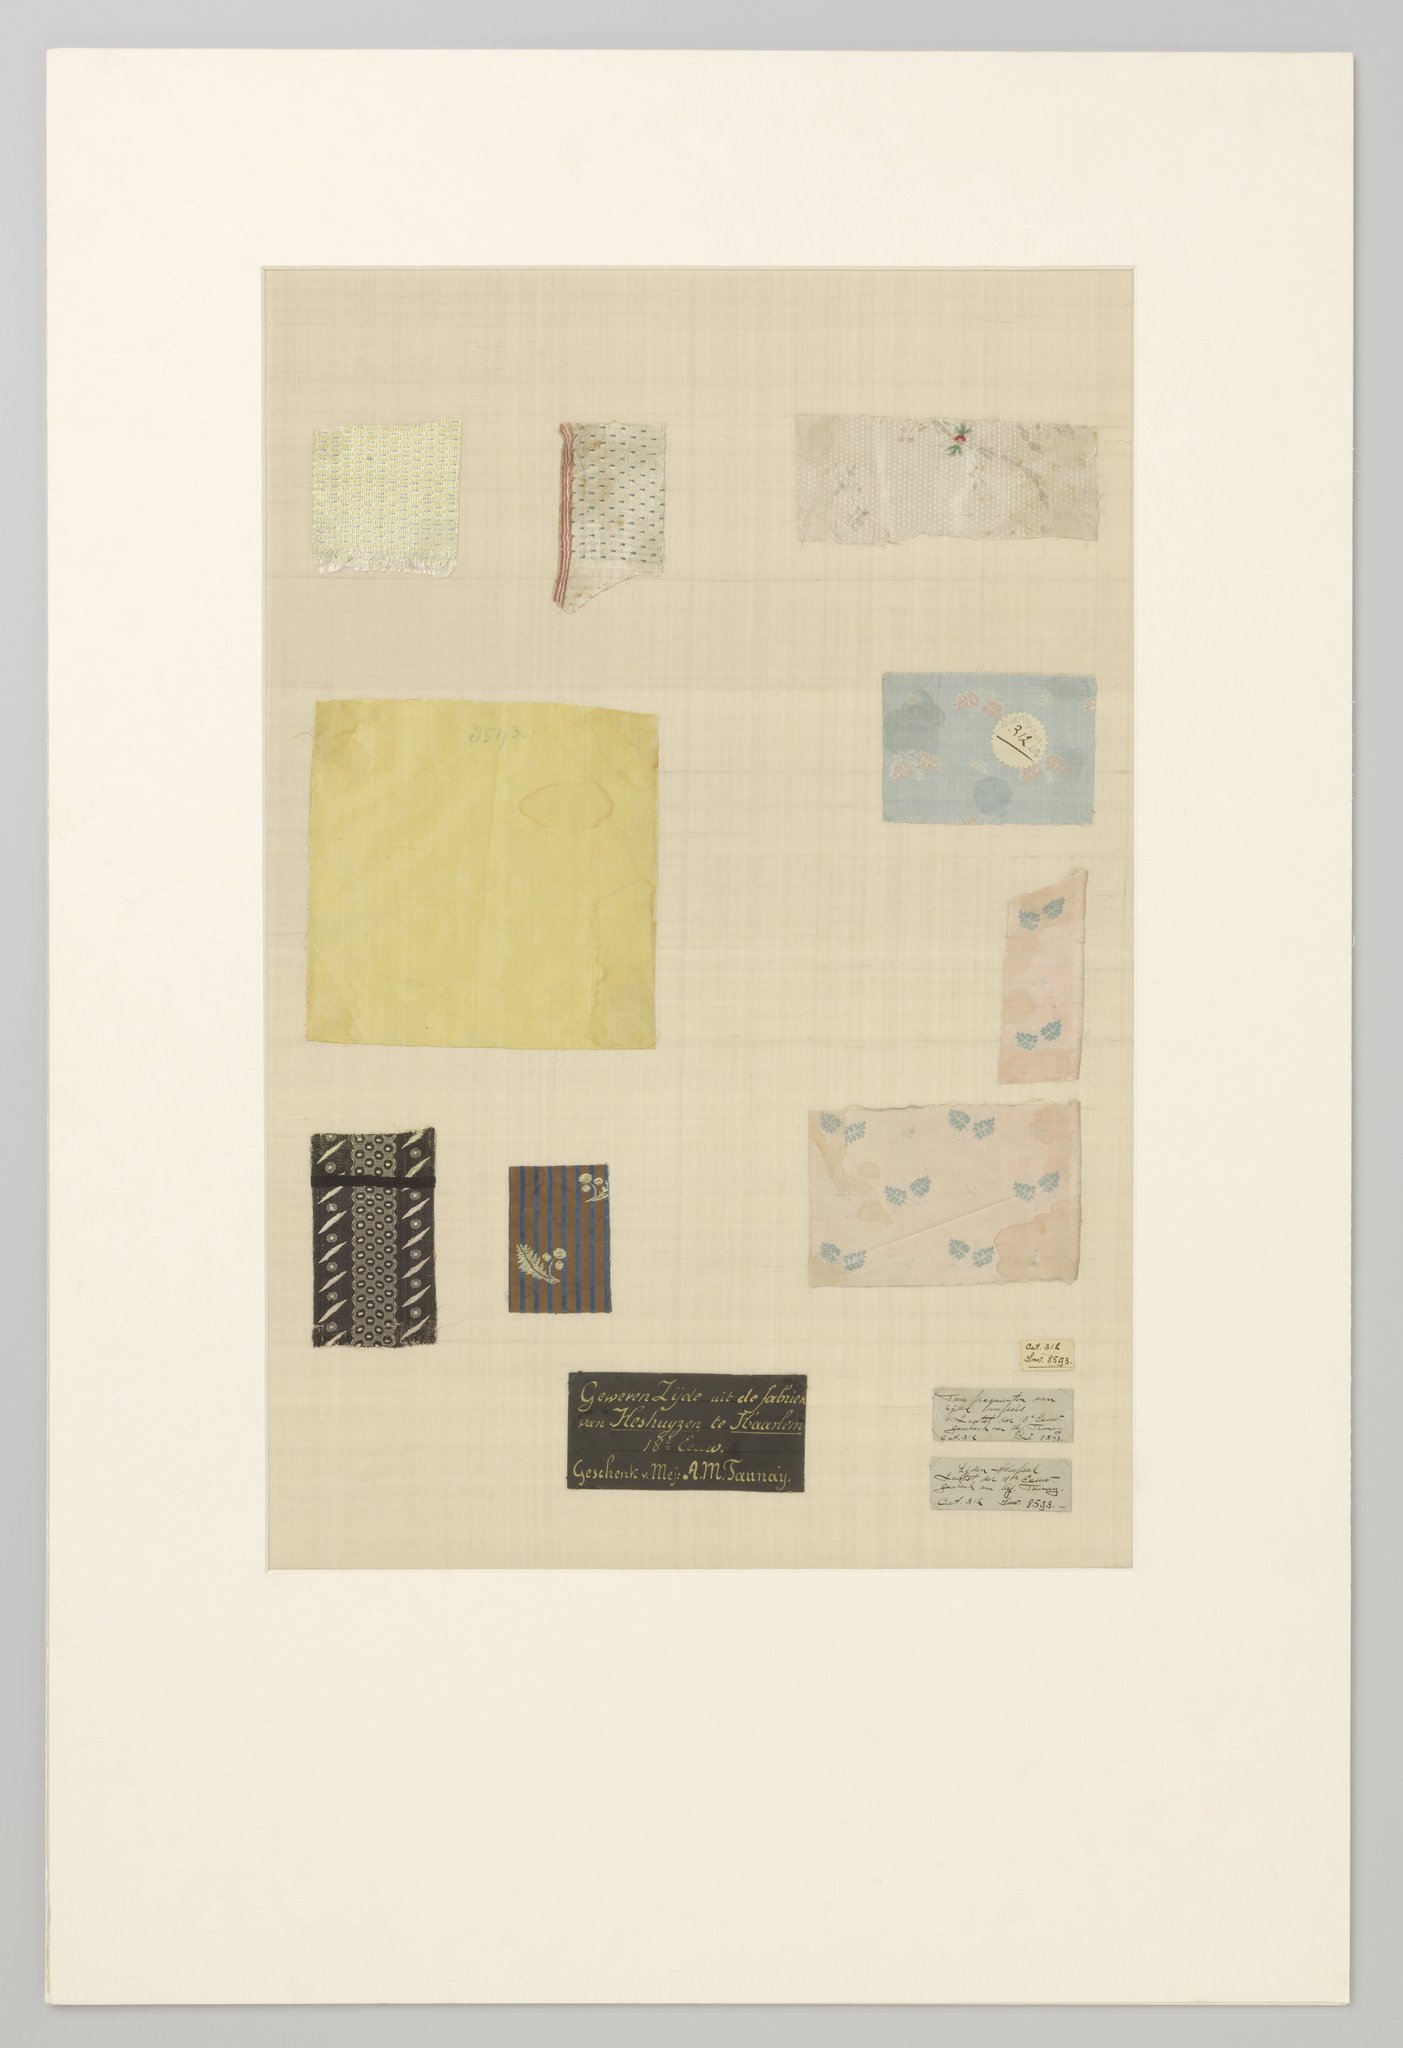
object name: fragment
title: Fragment zijdeweefsel.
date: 1750-1800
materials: silk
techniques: brocade, weave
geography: haarlem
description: Fragment zijdeweefsel. Een roze grond heeft rijen van lichtblauwe, dubbele bladeren op een witte steel, waartussen een kleine witte tak.